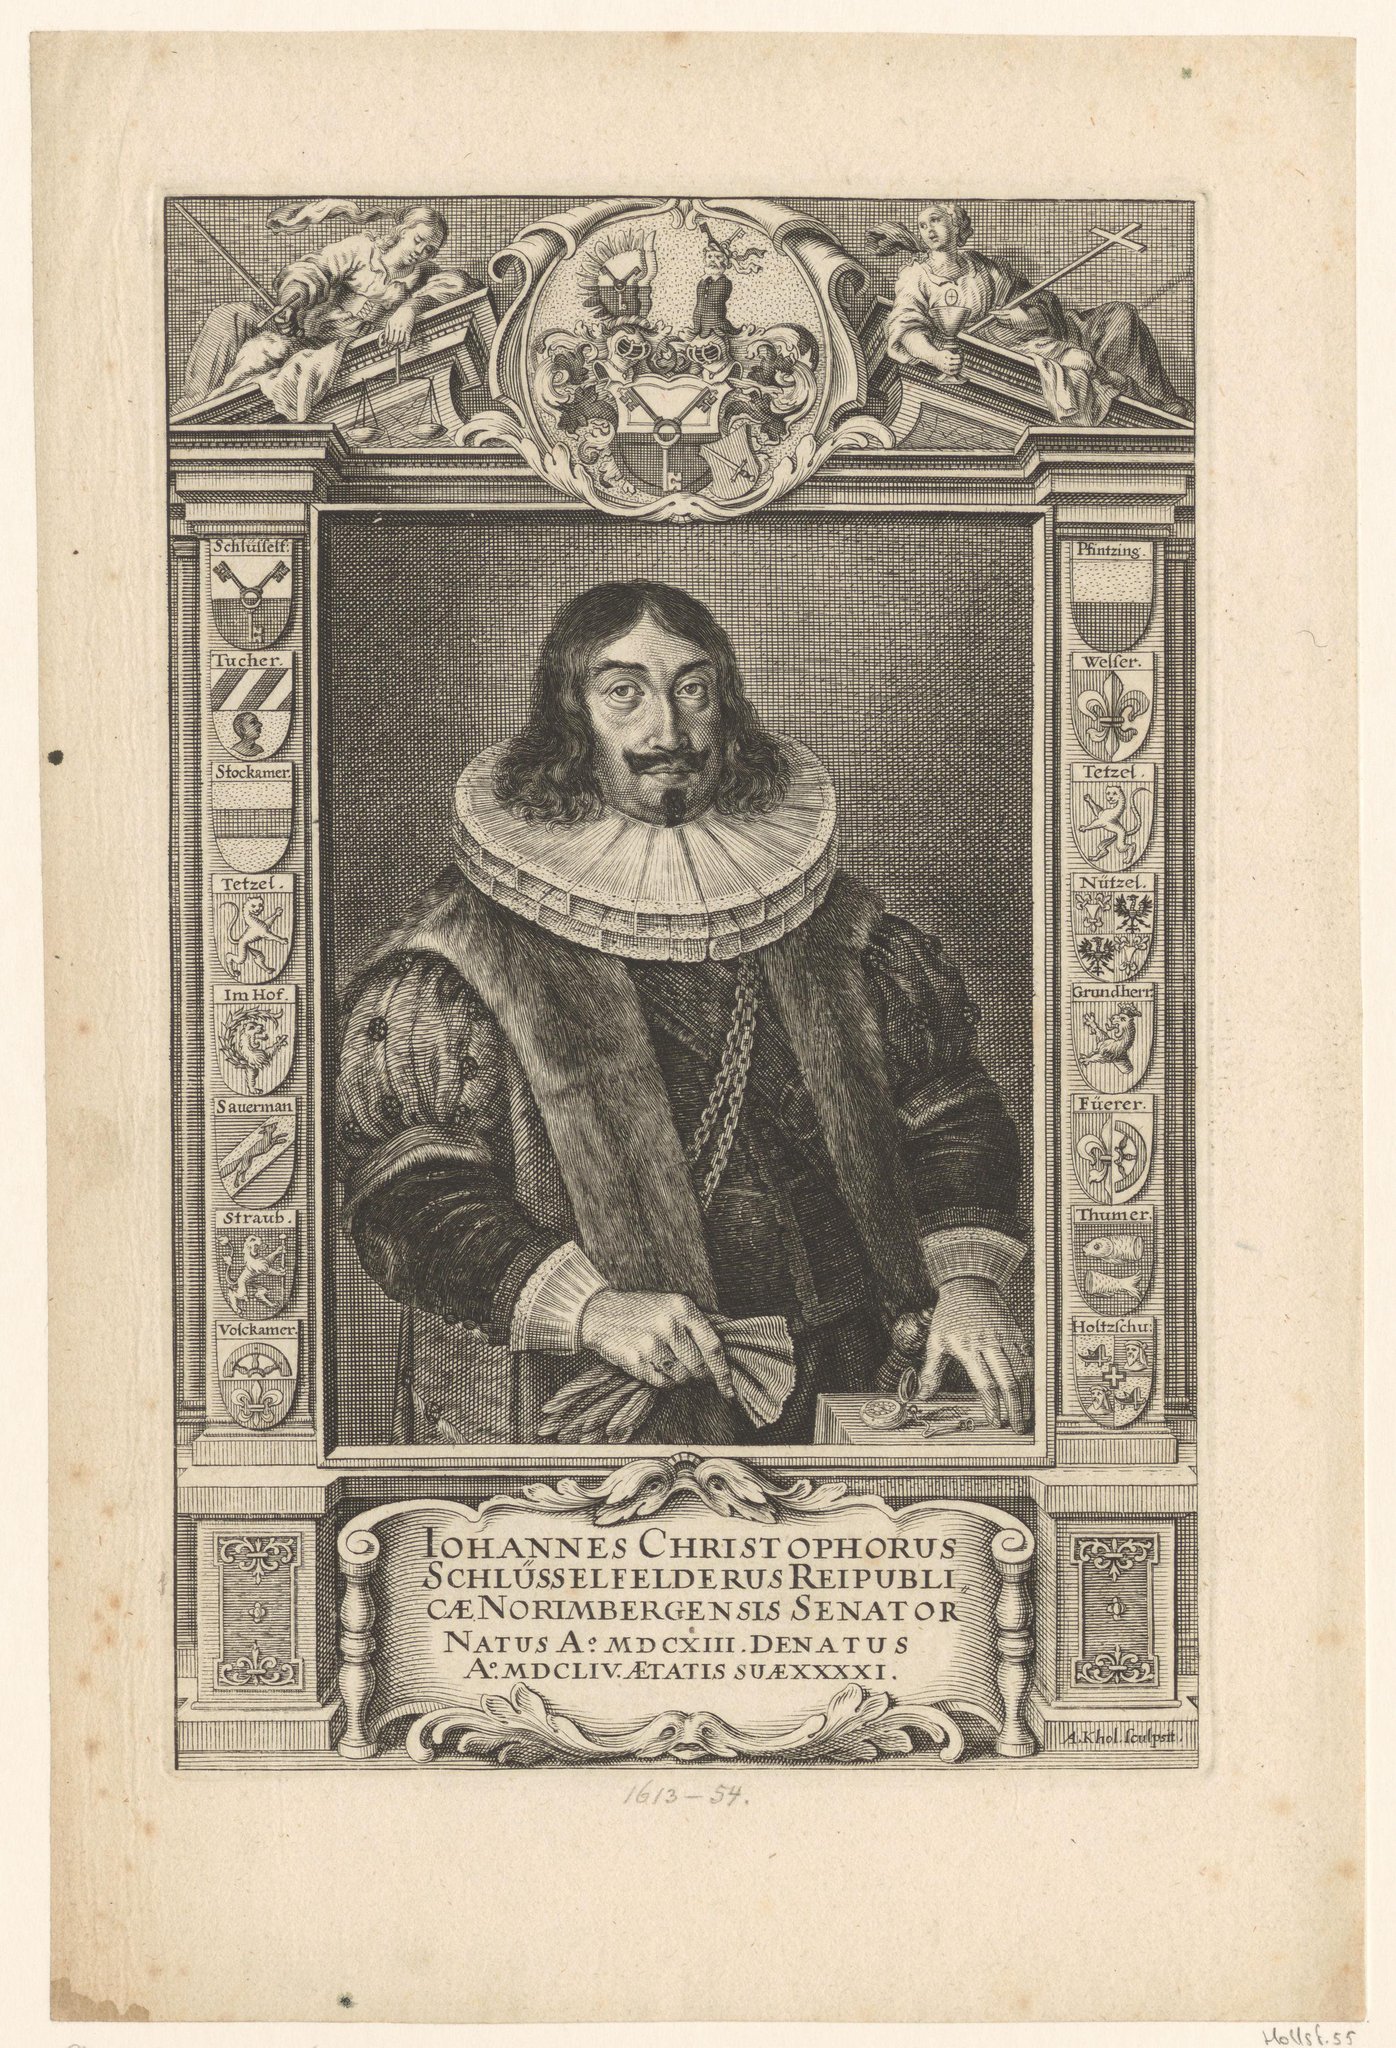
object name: print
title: Portret van Johann Christoph Schlüssefelder op 41-jarige leeftijd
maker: andreas kohl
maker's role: print maker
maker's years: 1624-1657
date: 1654-1657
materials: paper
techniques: engraving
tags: historical persons, counsellor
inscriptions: collector's mark: Lugt 2228